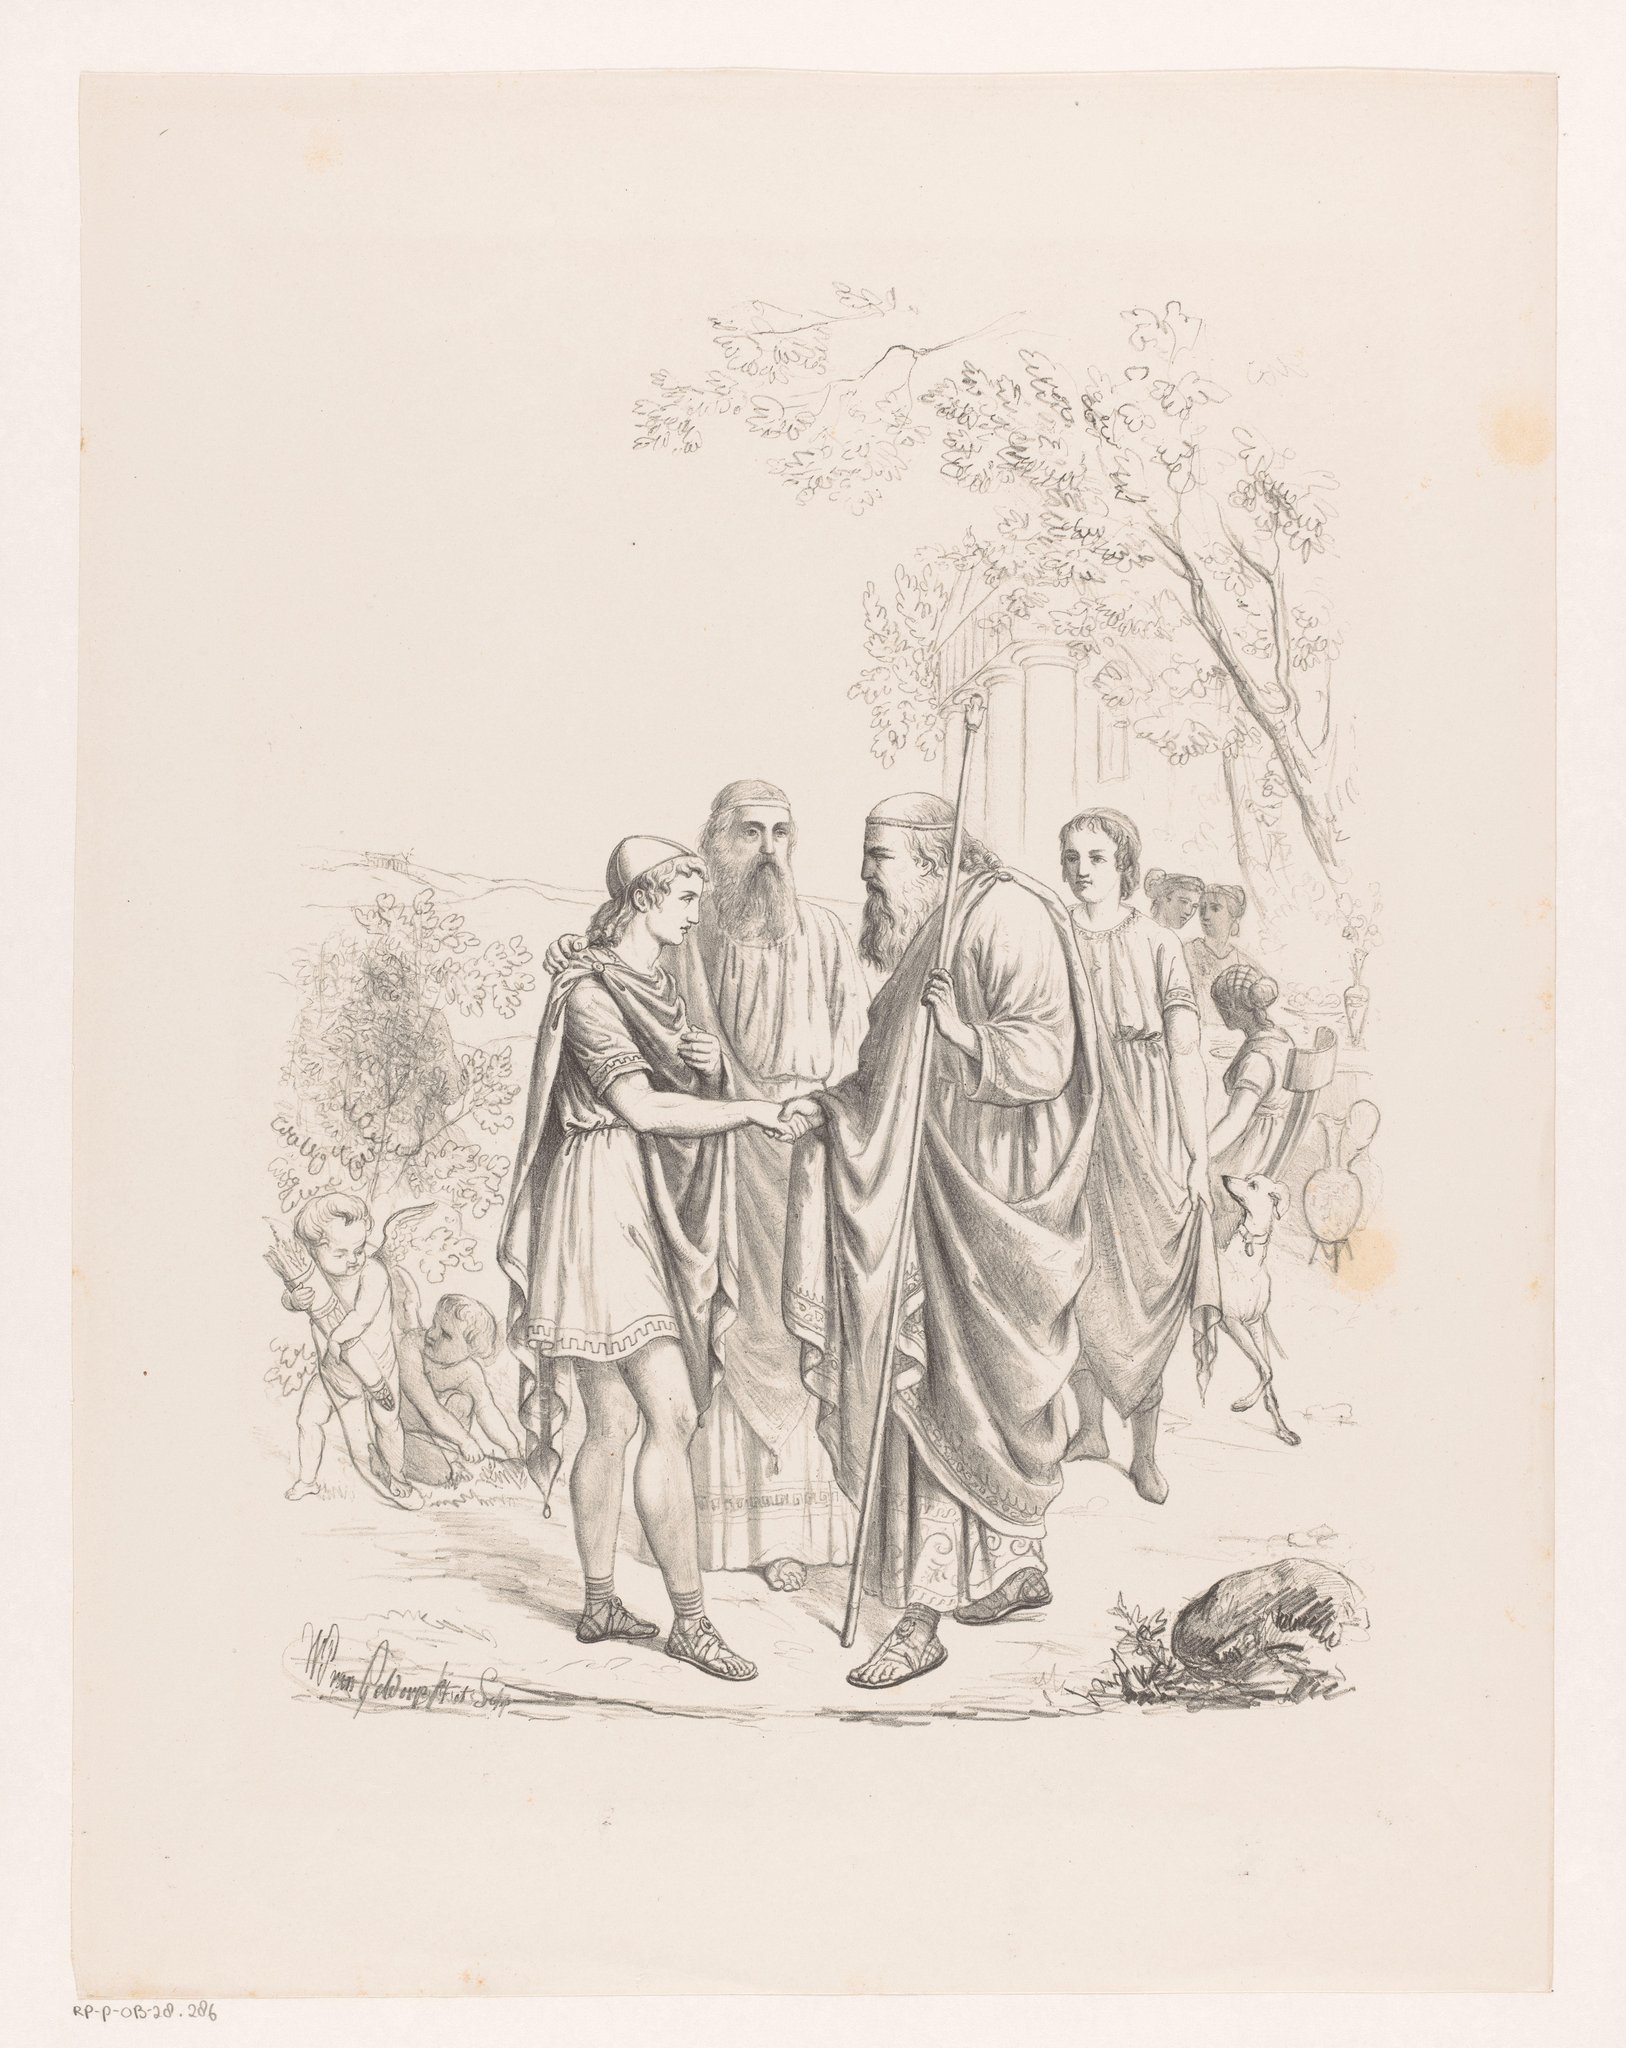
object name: print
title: Kunst-Album door W. P. van Geldorp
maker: wilhelmus petrus van geldorp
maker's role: print maker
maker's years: 1832-1900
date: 1870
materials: paper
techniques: lithograph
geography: rotterdam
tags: shaking hands, 'dextrarum junctio', telemachus' encounter with nestor at the sea-shore during a sacrifice to neptune, nestor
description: Telemachus is van huis vertrokken om zijn vader Odysseus te vinden. Athena, vermomd als een oude man genaamd Mentor, begeleid hem. Zij geeft hem de moed om koning Nestor aan te spreken.